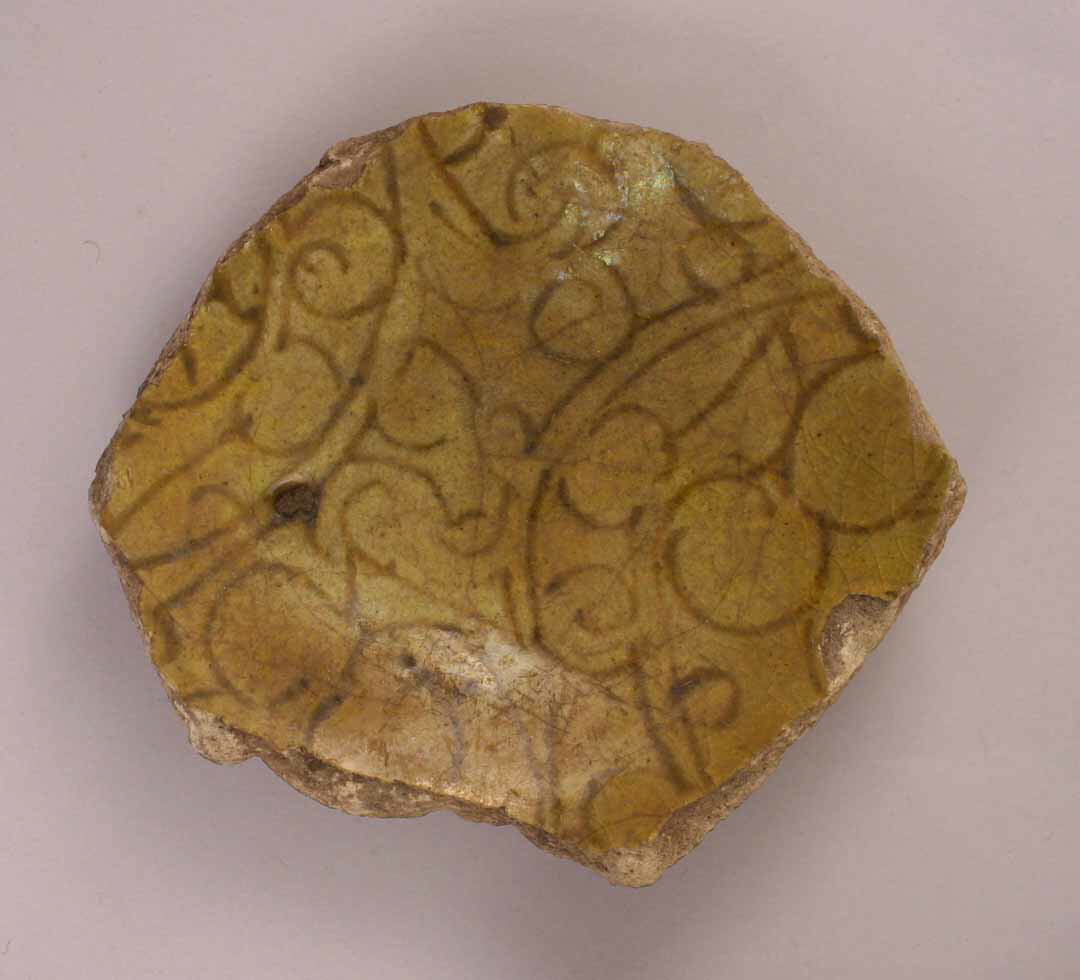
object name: ceramic fragment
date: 1201-1400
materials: earthenware, glaze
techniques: incising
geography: egypt